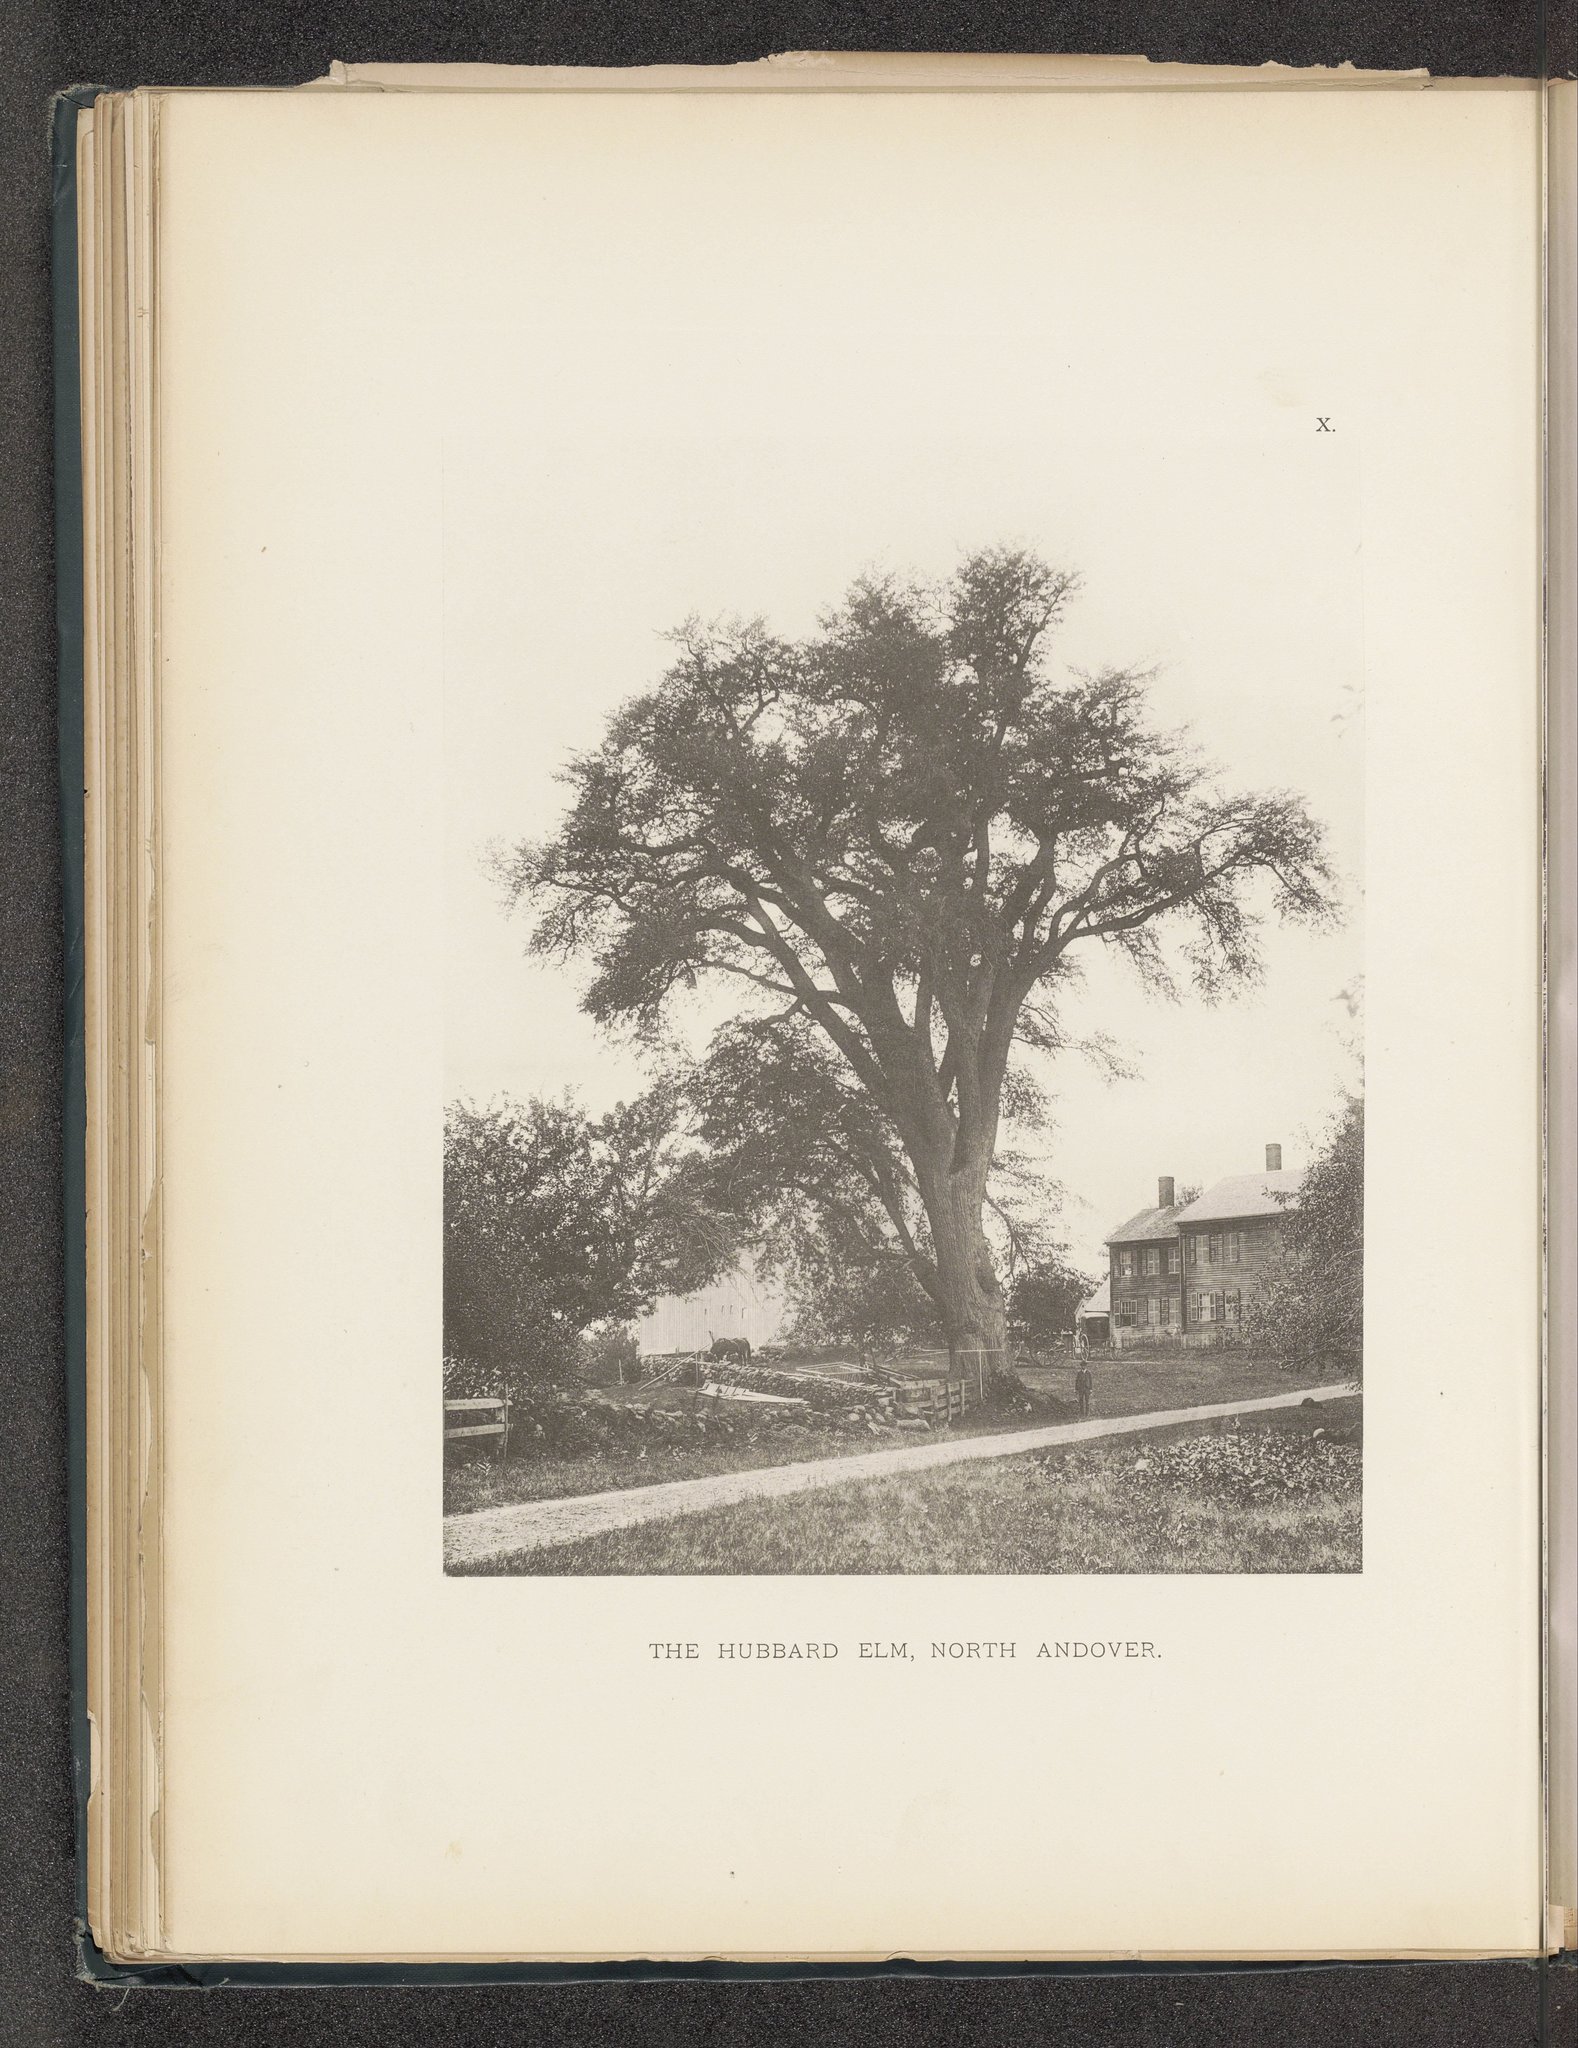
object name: photomechanical print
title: Gezicht op een iep naast een boerderij te North Andover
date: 1880-1890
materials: paper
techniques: photograph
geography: north andover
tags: trees: elm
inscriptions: number: ‘X.’